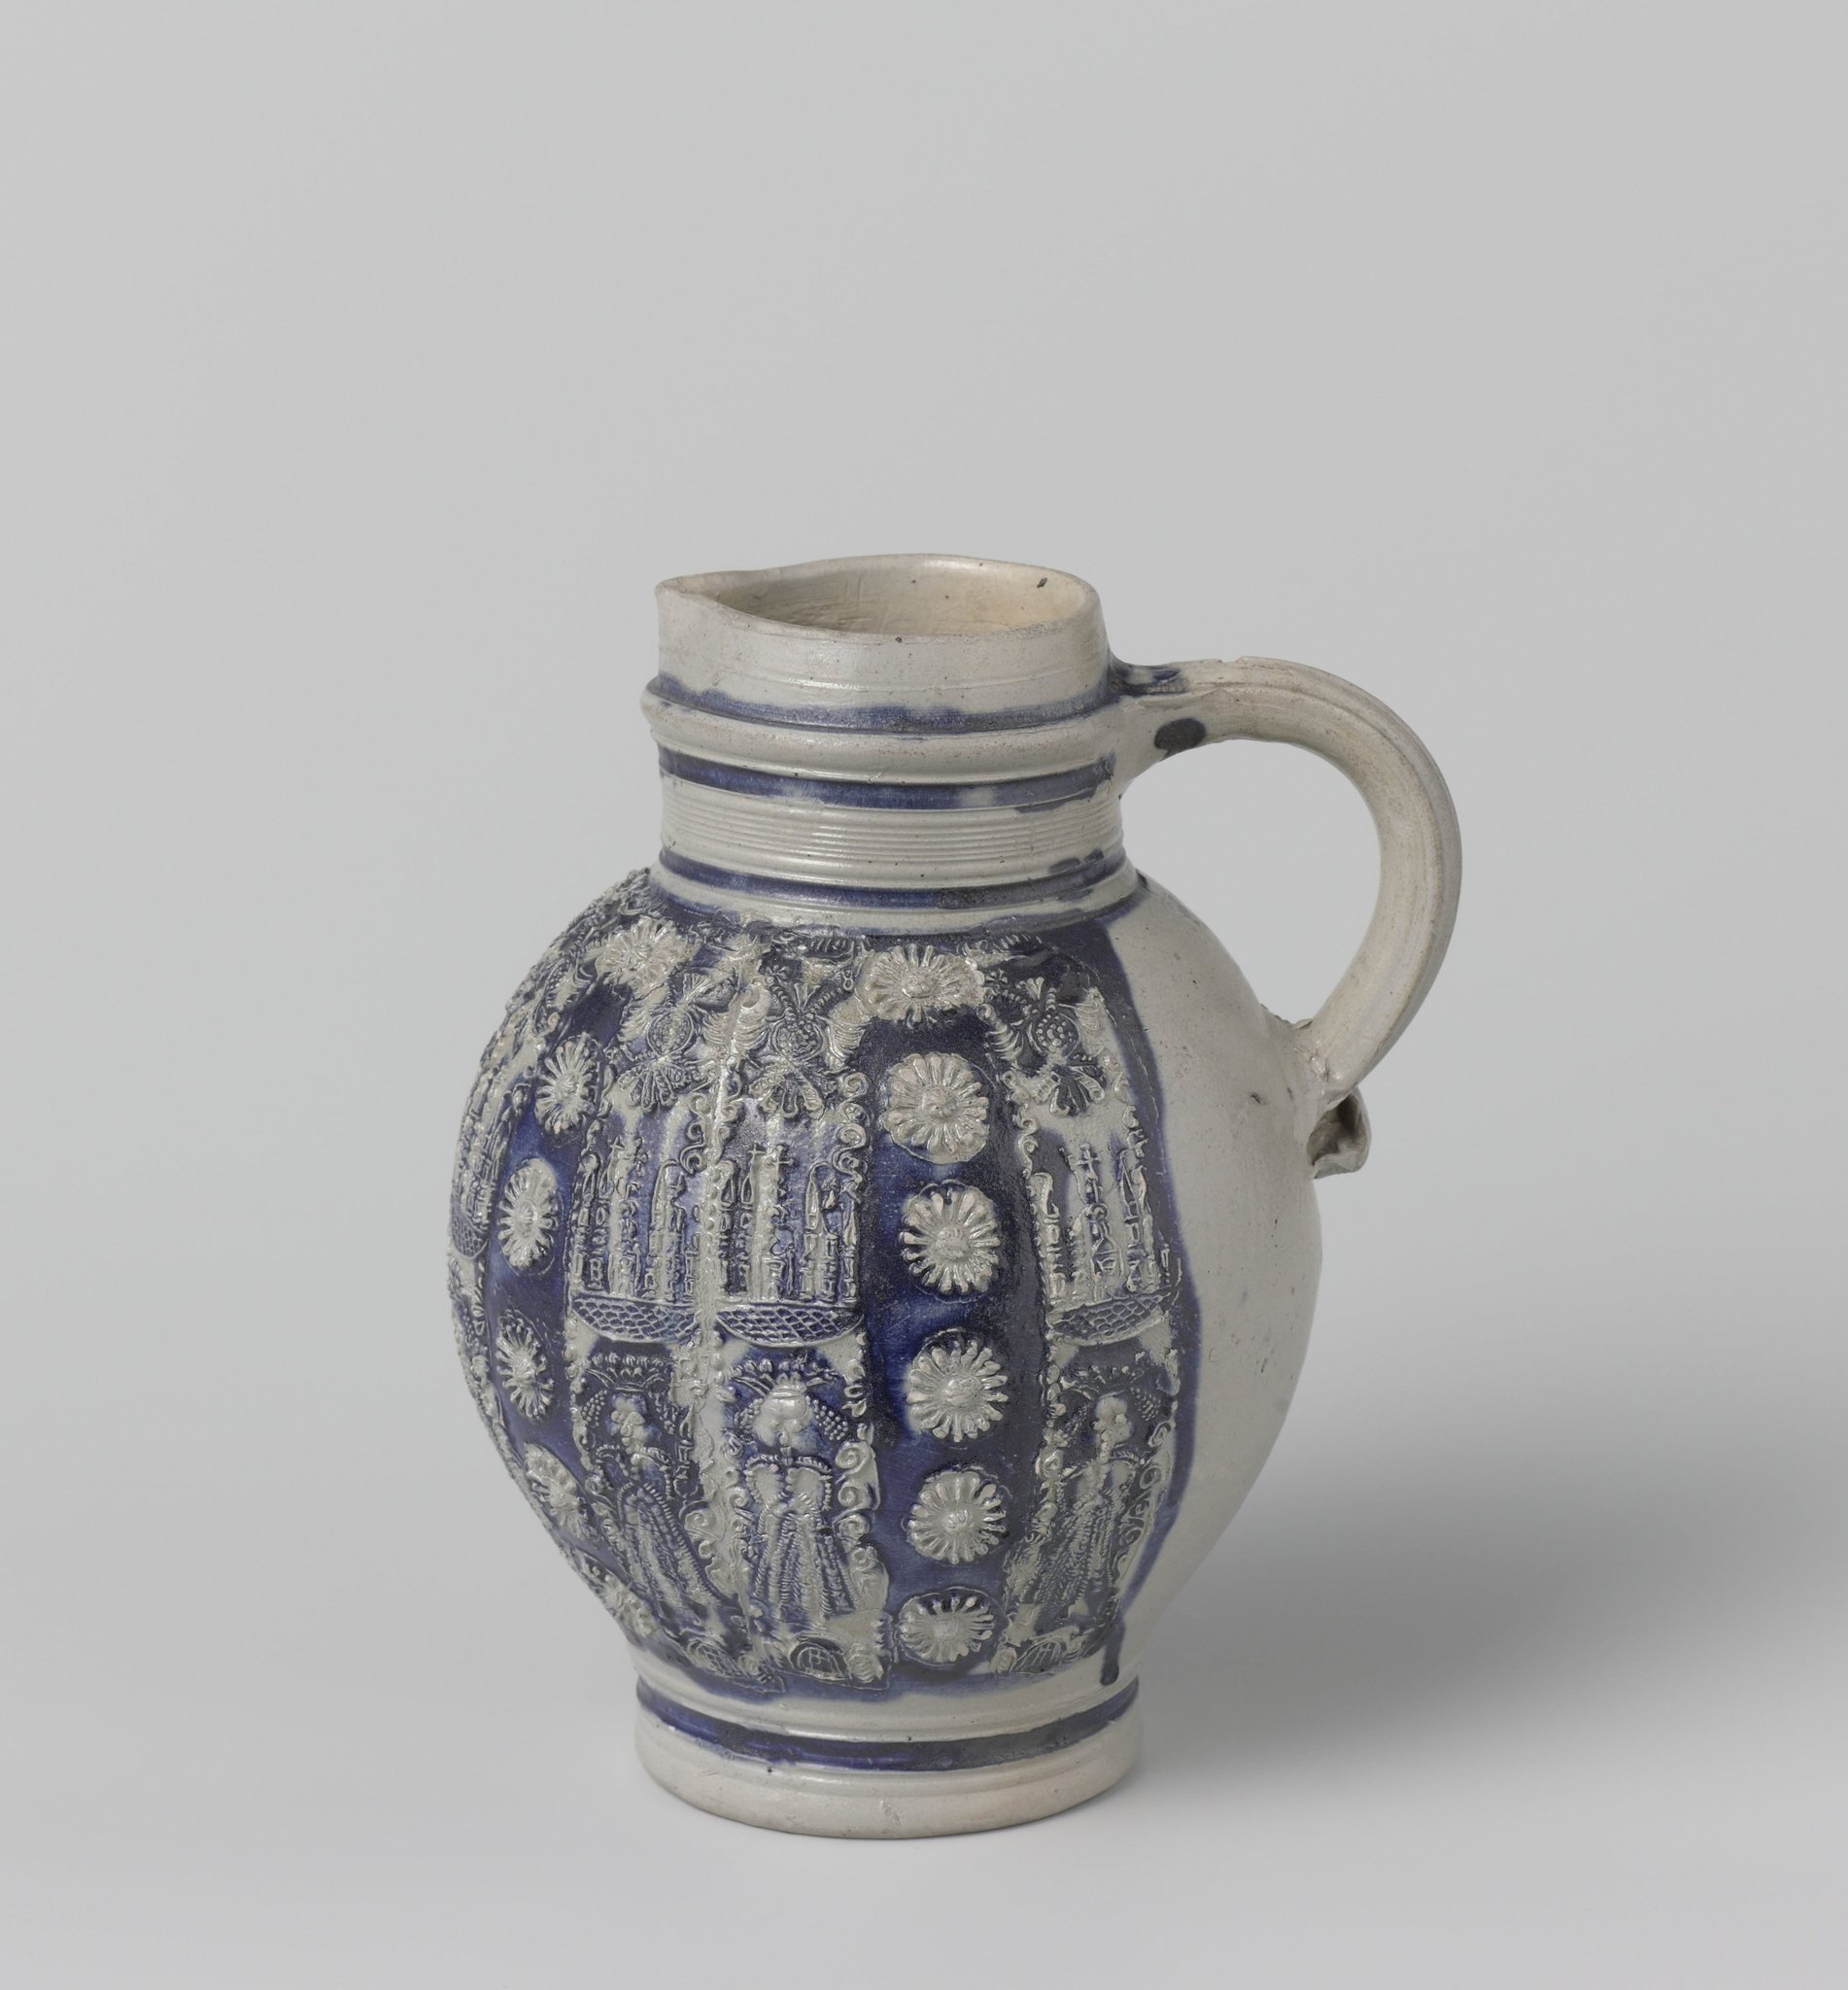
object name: ewer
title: Jug with towers, female figures and flower roundels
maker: Anonymous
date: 1690-1720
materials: cobalt, glaze, stoneware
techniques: firing, forming, relief, turning, vitrification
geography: westerwald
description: Kan van steengoed op standring met een bolvormig lichaam en korte nek met een geknepen tuit. Het C-vormige oor is bevestigd aan de nek en de schouder. Profielen op de nek en voet. Gedeeltelijk bedekt met kobaltblauw. Op de buik negen verticale banden in reliëf met een gedrukte en opgelegde decoratie van ranken, (kerk)torens en gekroonde vrouwfiguren. Behalve één zijn de banden met telkens twee naast elkaar geplaatst, gescheiden door een band met kleine bloemrozetten in reliëf. Blauwe lijnen op de nek en voet. Westerwald.